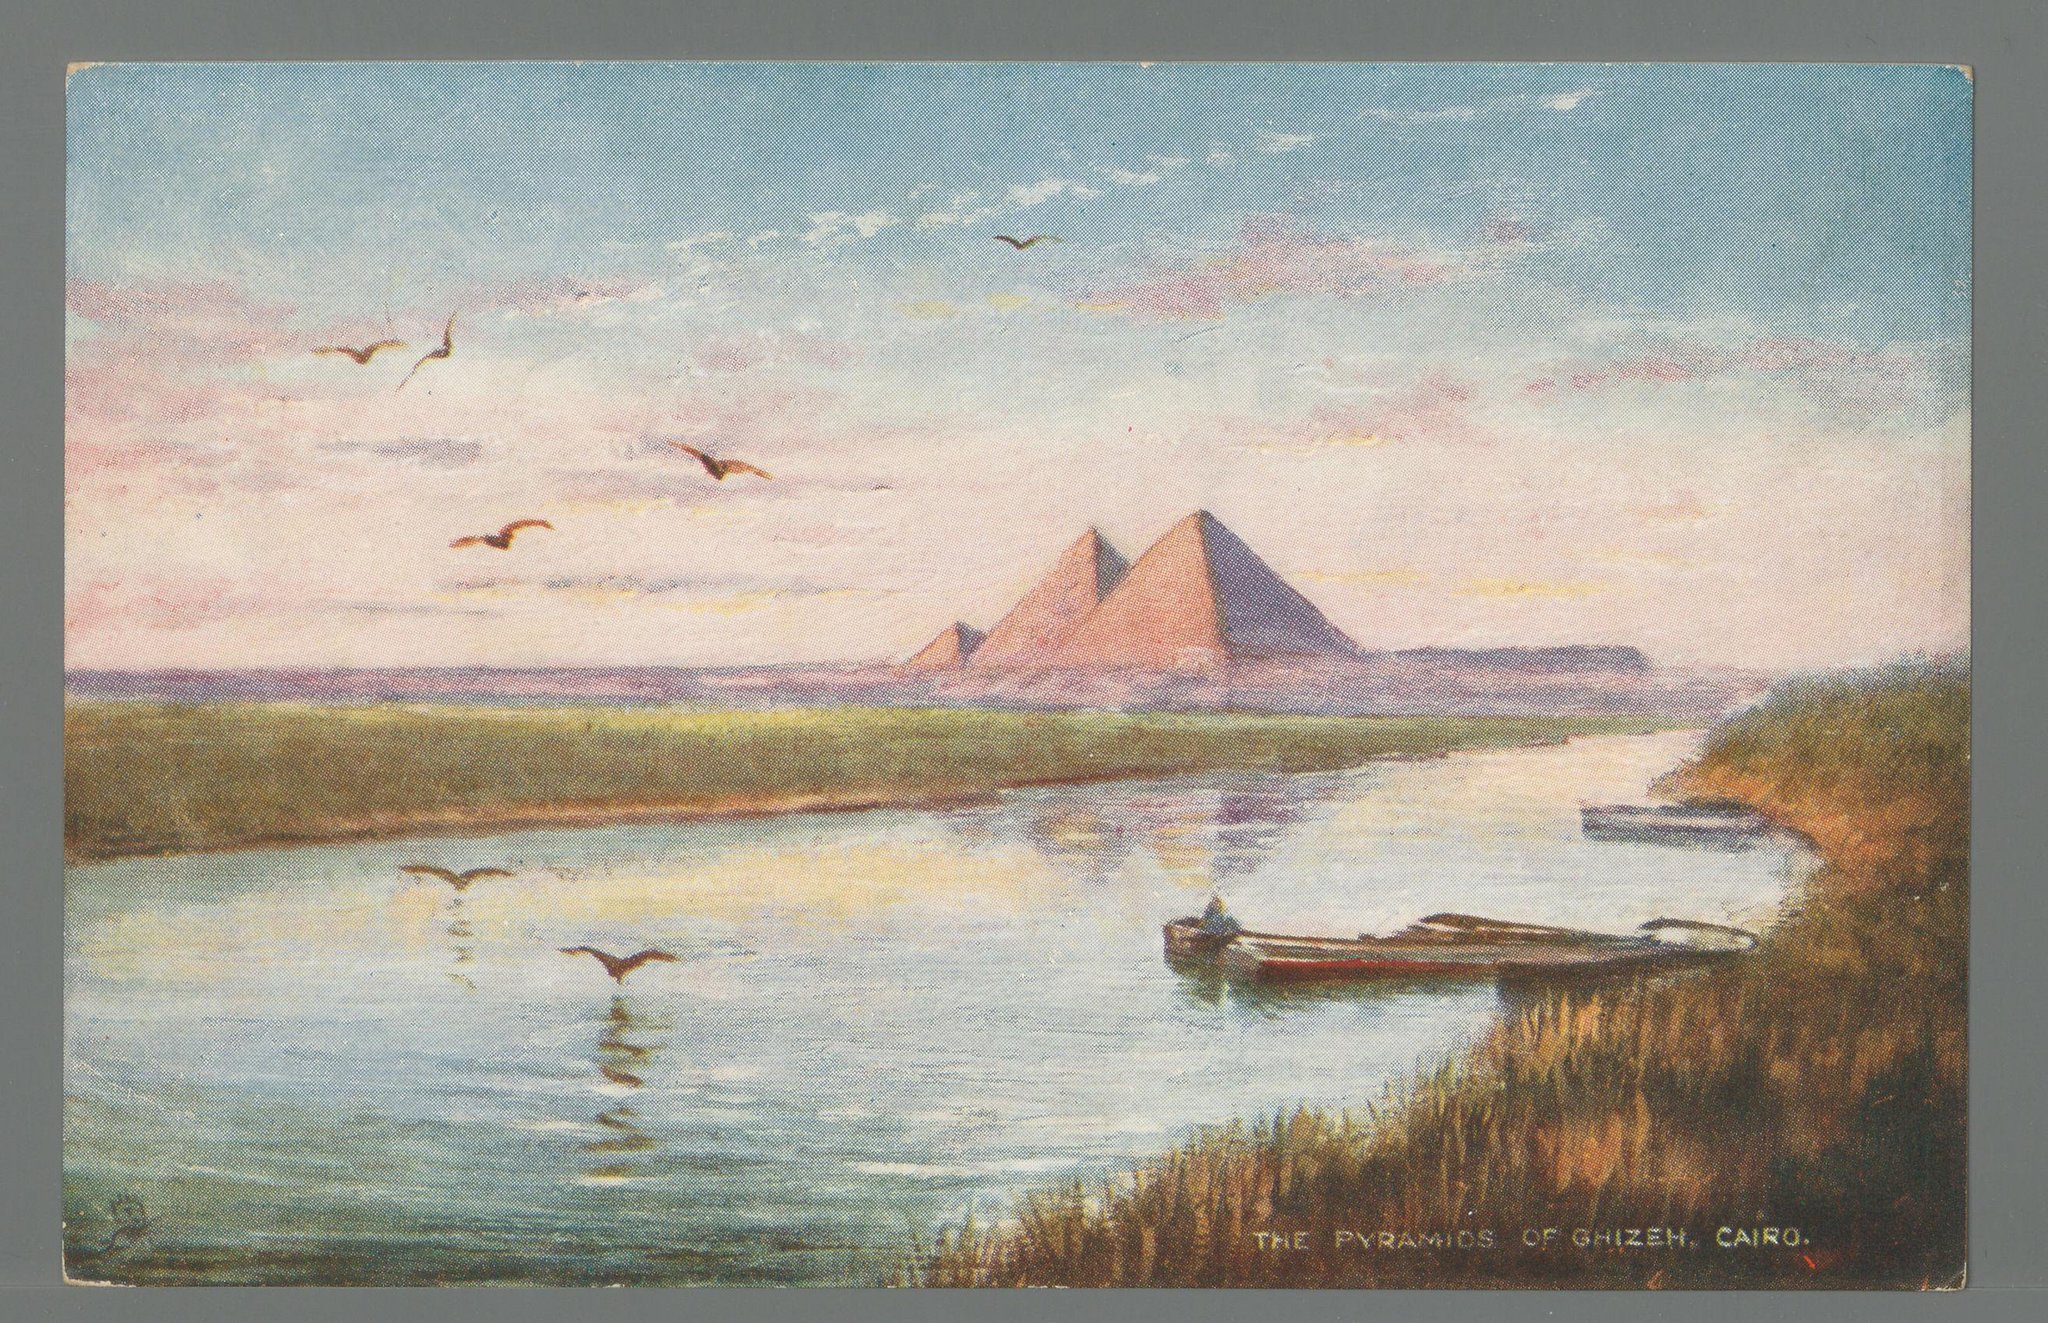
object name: photomechanical print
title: Oilette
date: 1905-1912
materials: cardboard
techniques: color autotype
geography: england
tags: river, quadrangular pyramid